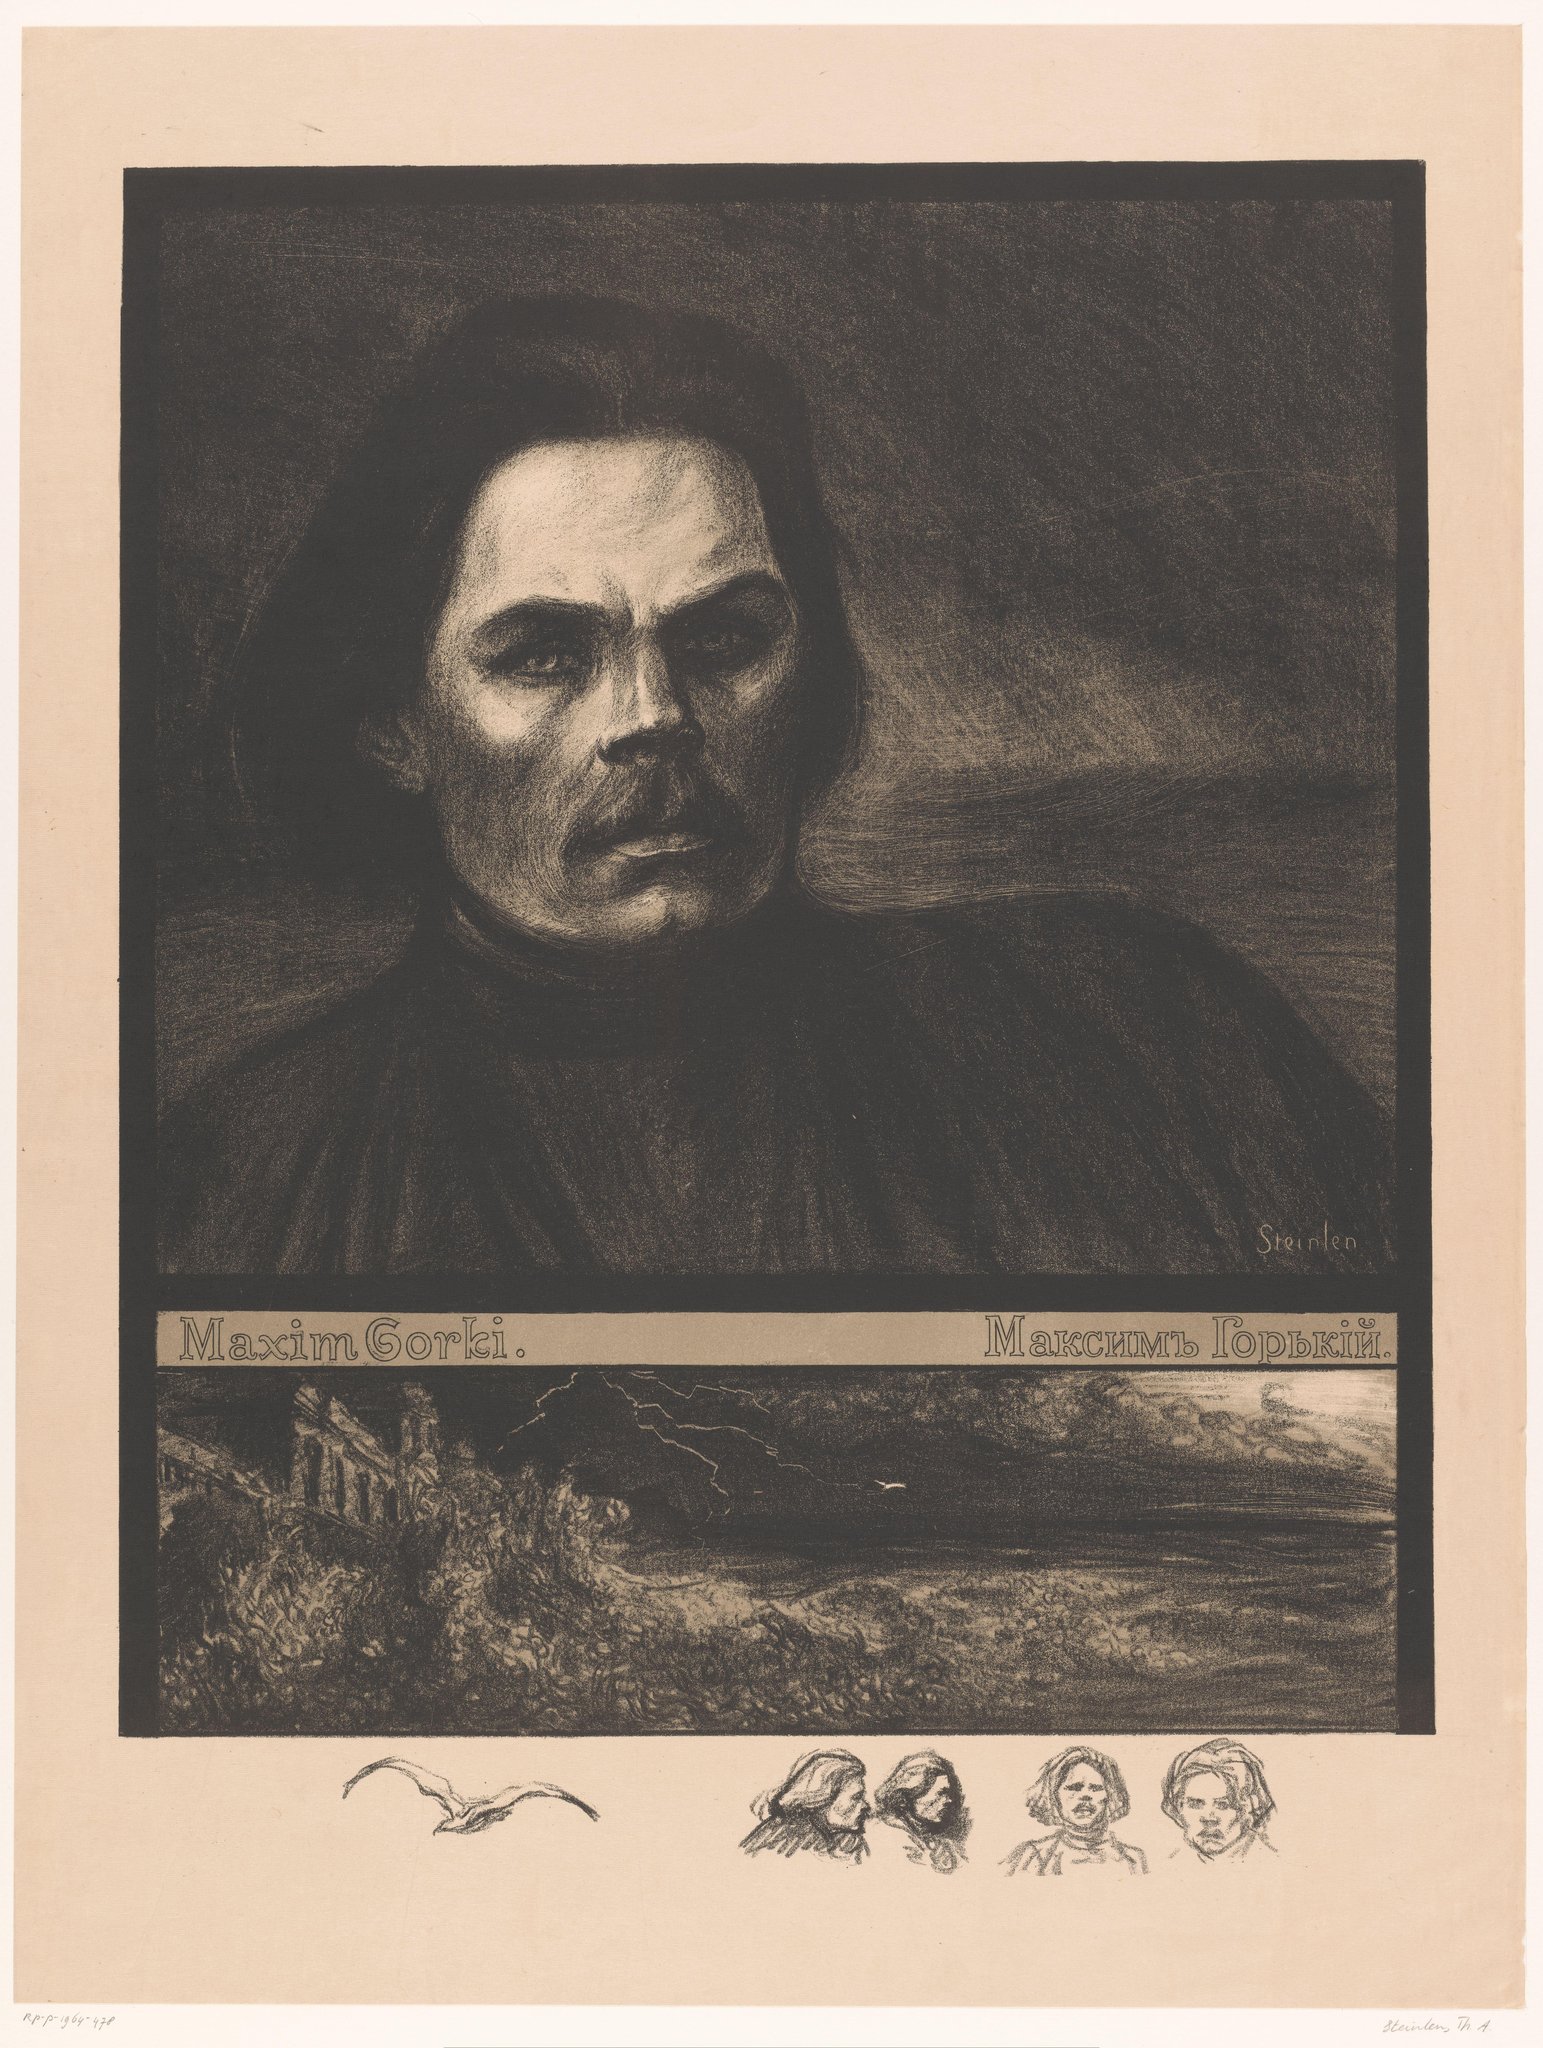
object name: print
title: Portret van Maksim Gorki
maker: théophile alexandre steinlen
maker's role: draughtsman, painter, print maker, sculptor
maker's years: 1859-1923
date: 1905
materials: paper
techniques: tone lithography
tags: historical persons, storm, sea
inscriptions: collector's mark: Lugt 2228